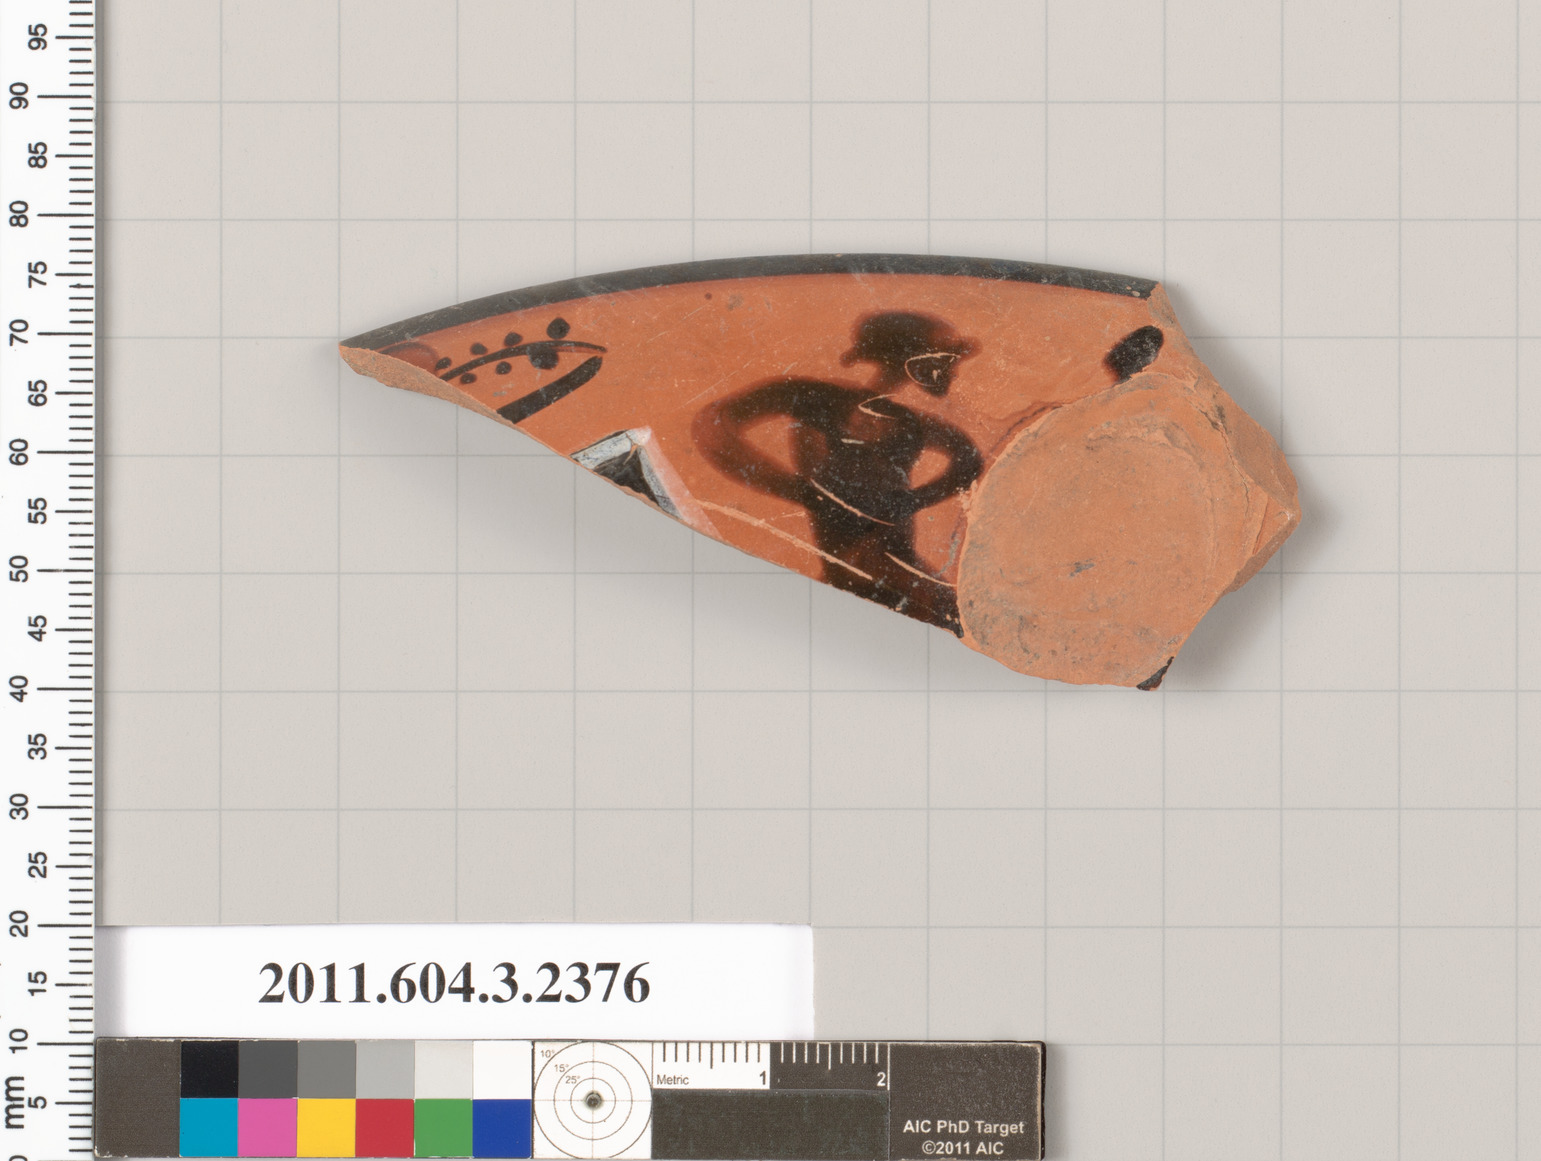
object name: kylix fragment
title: Terracotta rim fragment of a kylix: eye-cup (drinking cup)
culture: greek, attic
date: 534-501 BCE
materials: terracotta